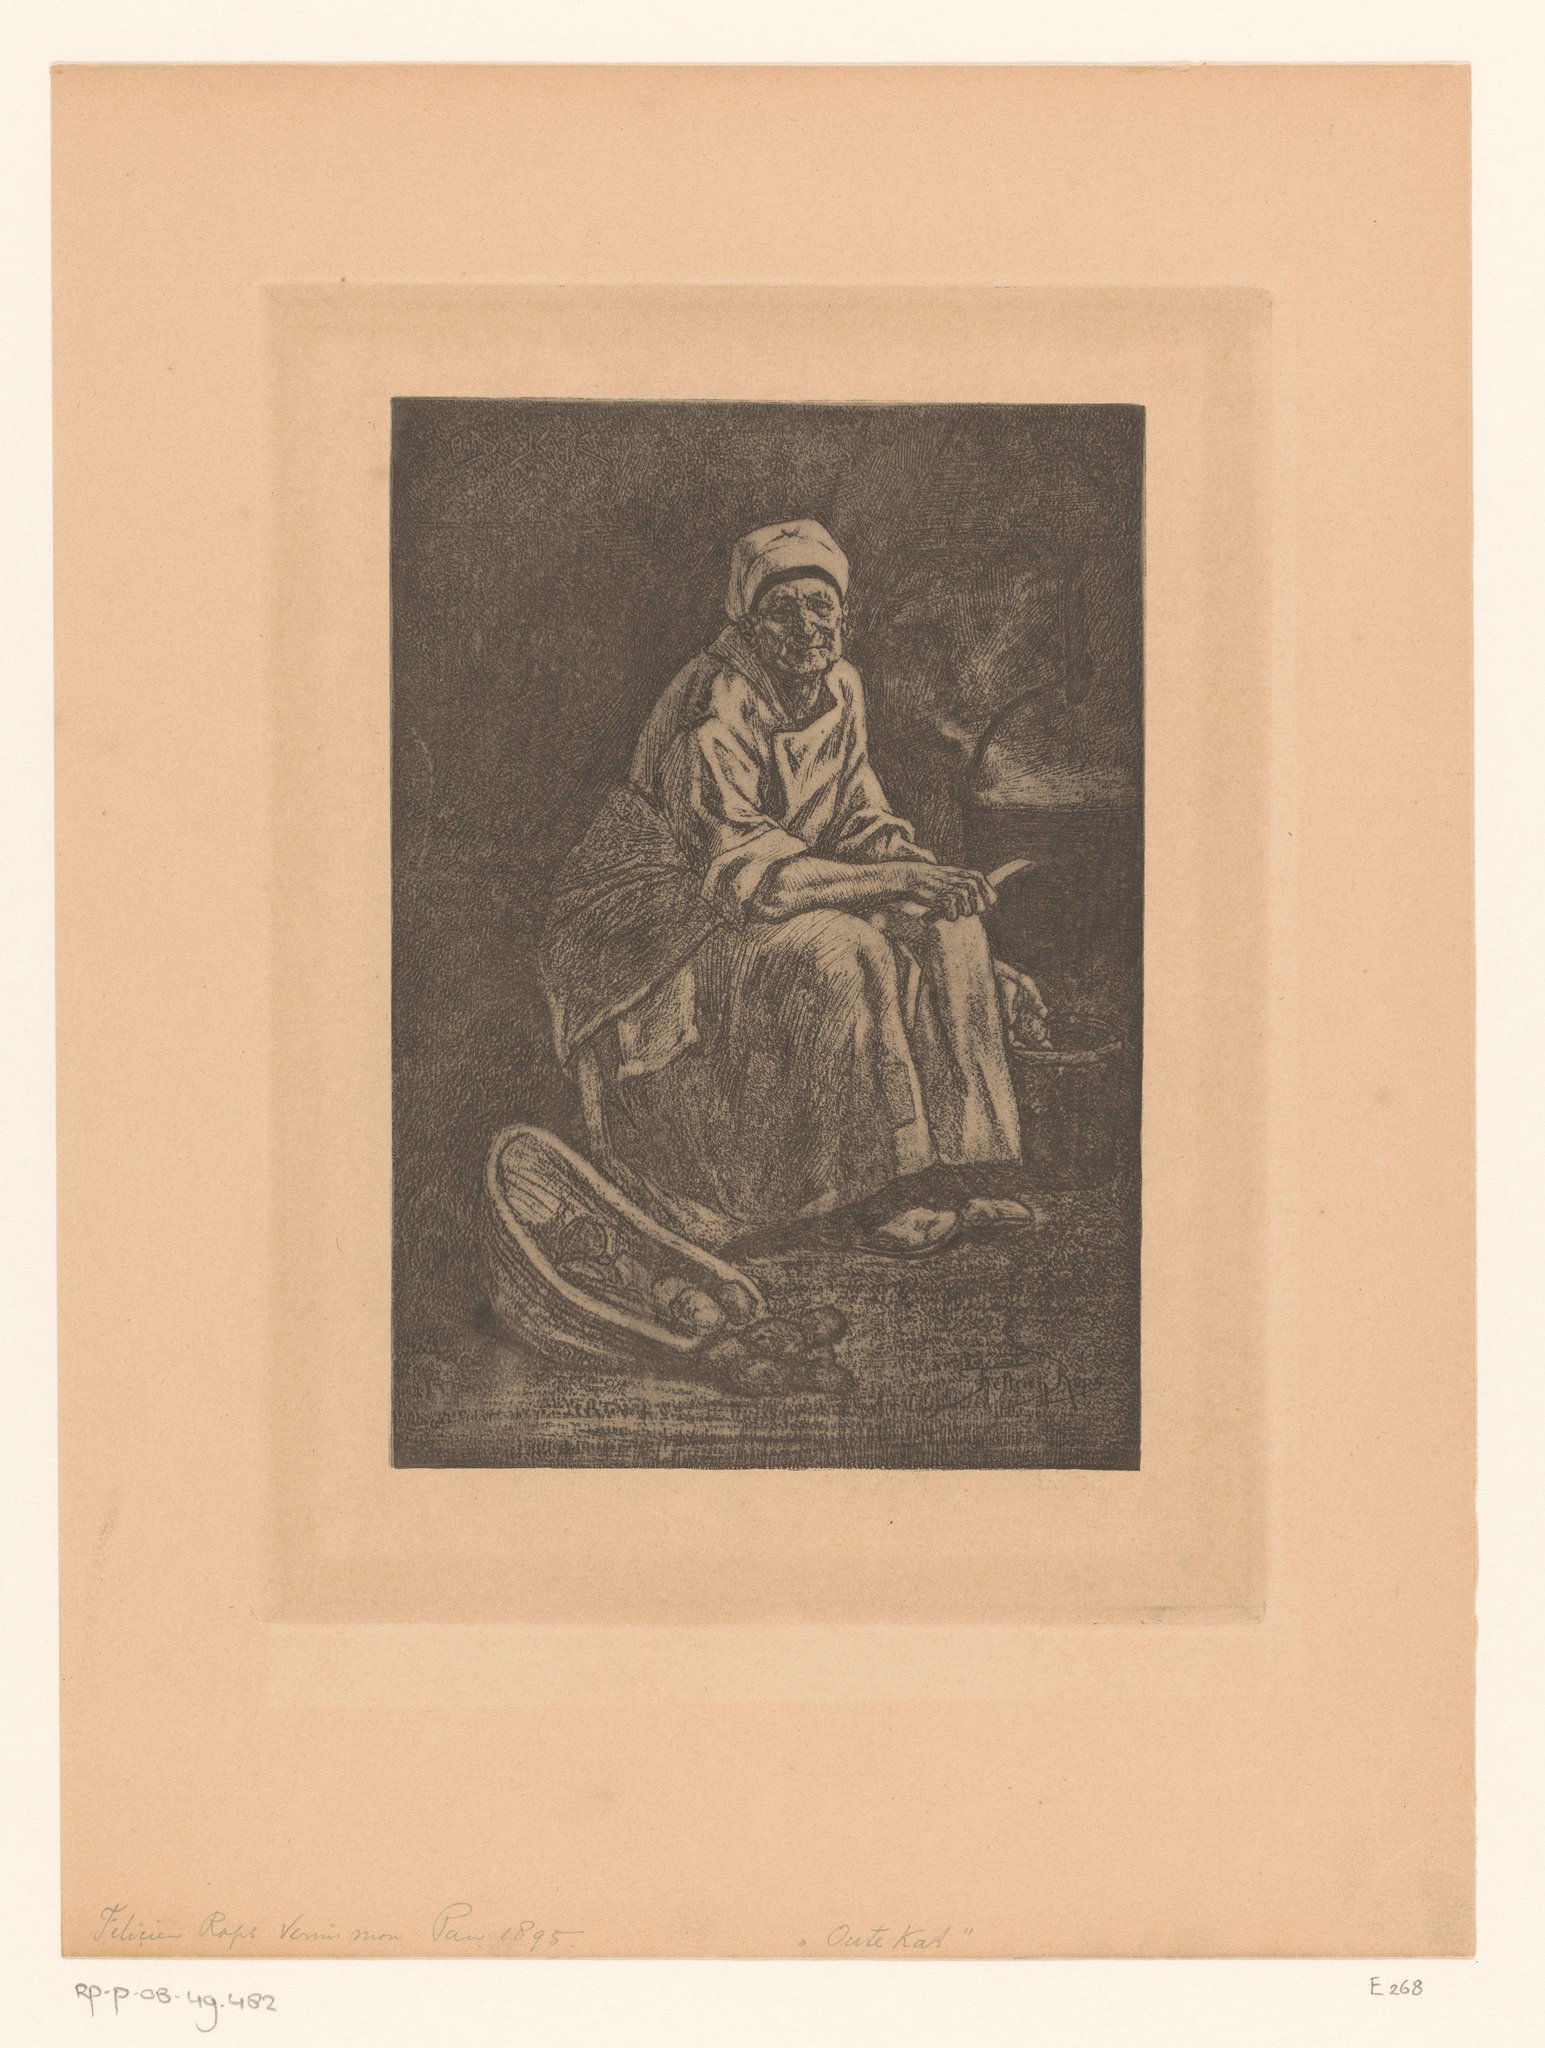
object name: photomechanical print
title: Oude Kate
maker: félicien rops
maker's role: draughtsman, print maker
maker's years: 1833-1898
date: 1895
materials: paper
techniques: photoaquatint, roulette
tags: old woman, potatoes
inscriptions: collector's mark: Lugt 2228